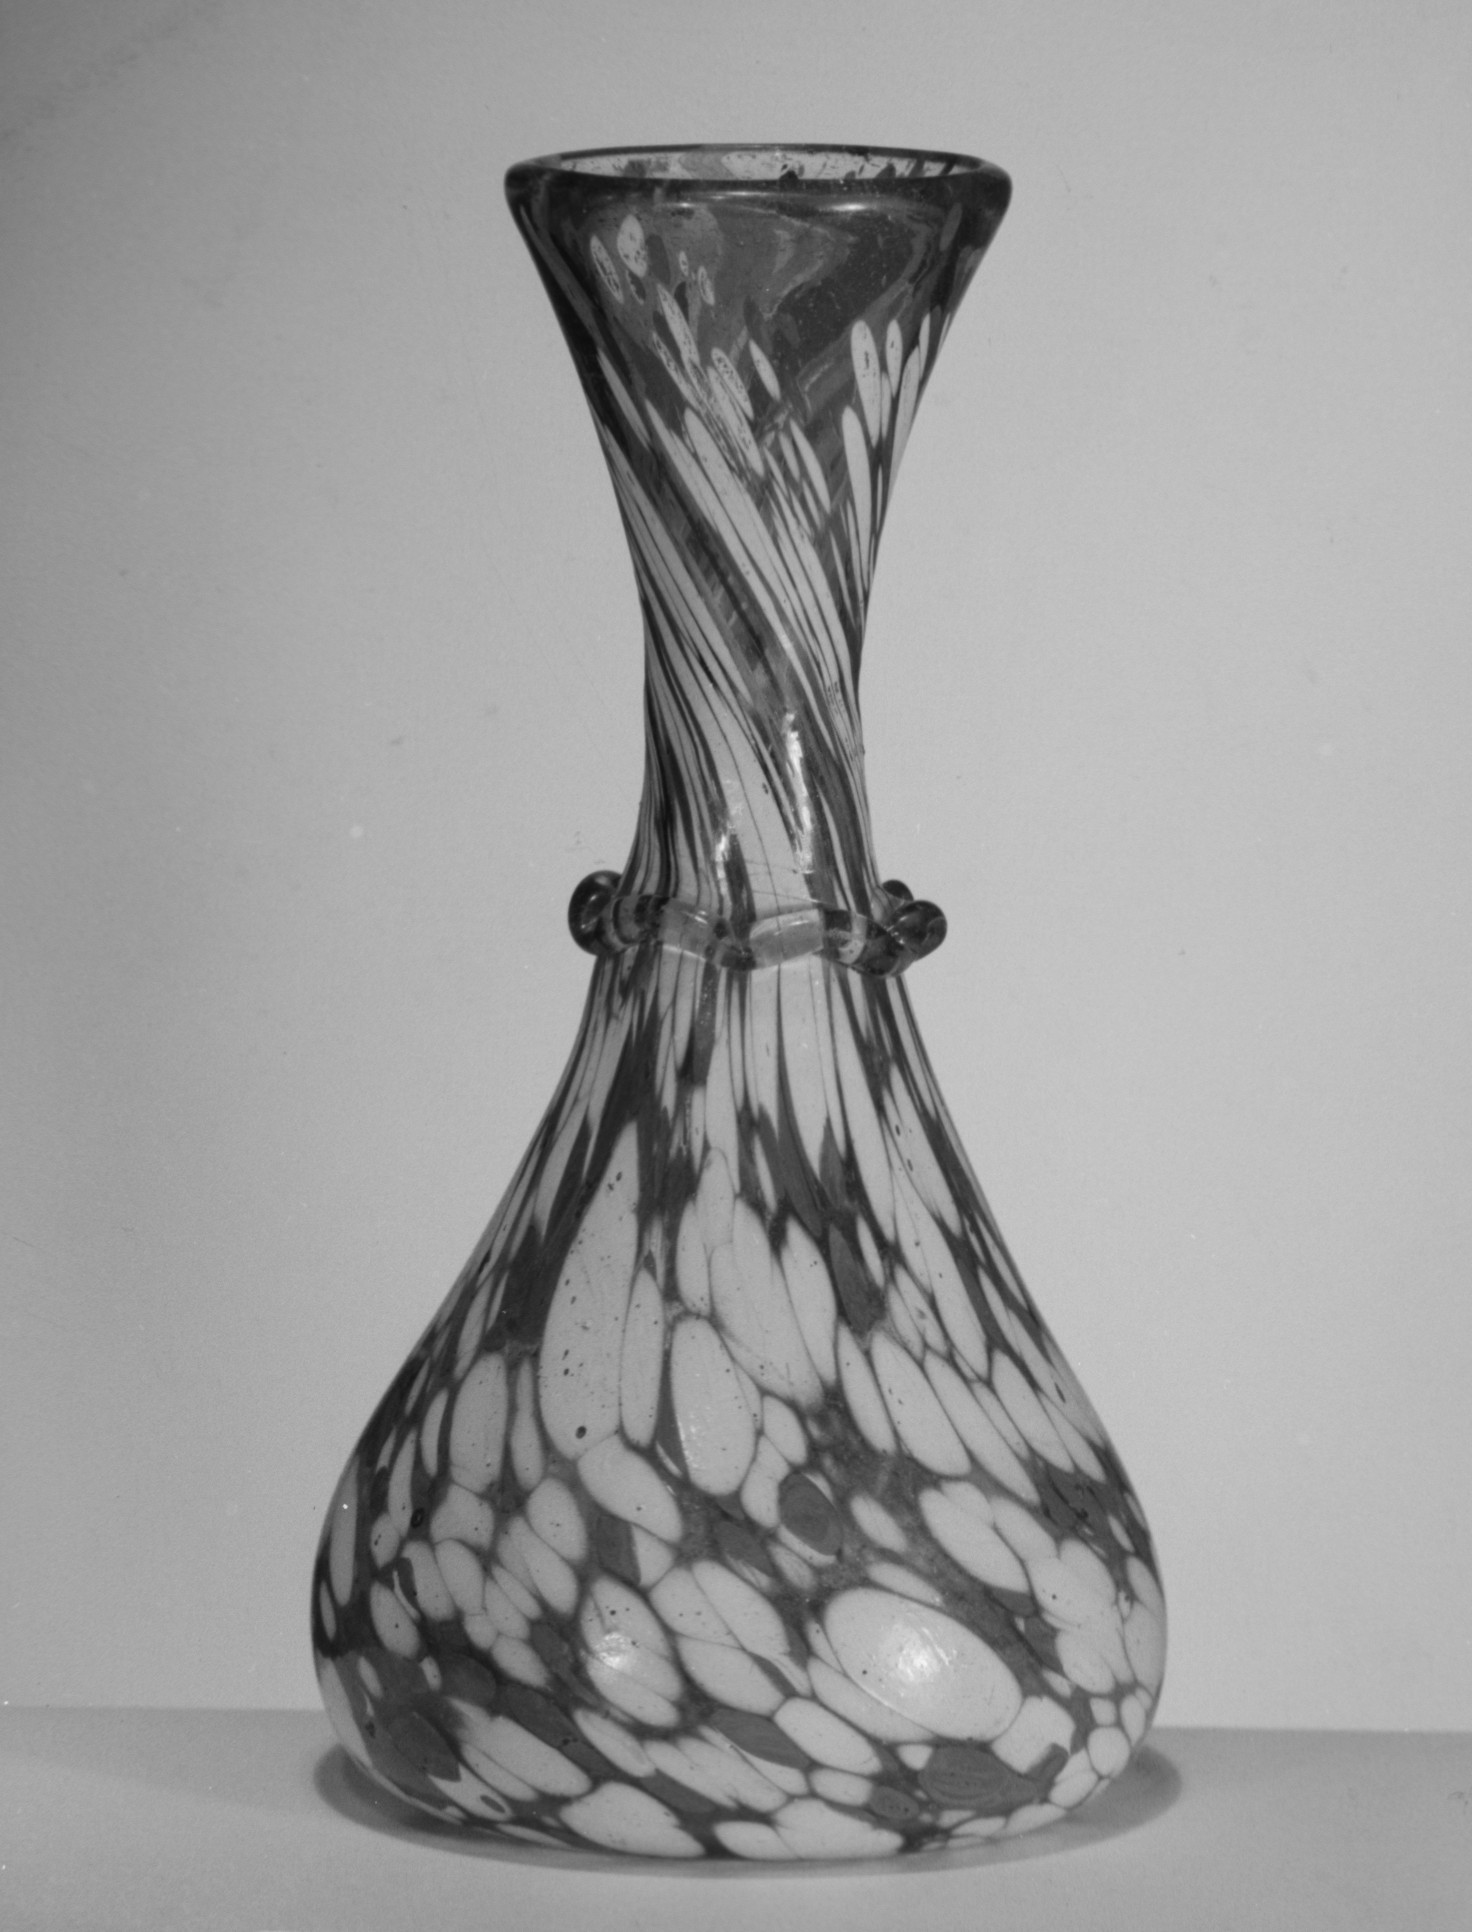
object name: carafe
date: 1601-1700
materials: glass